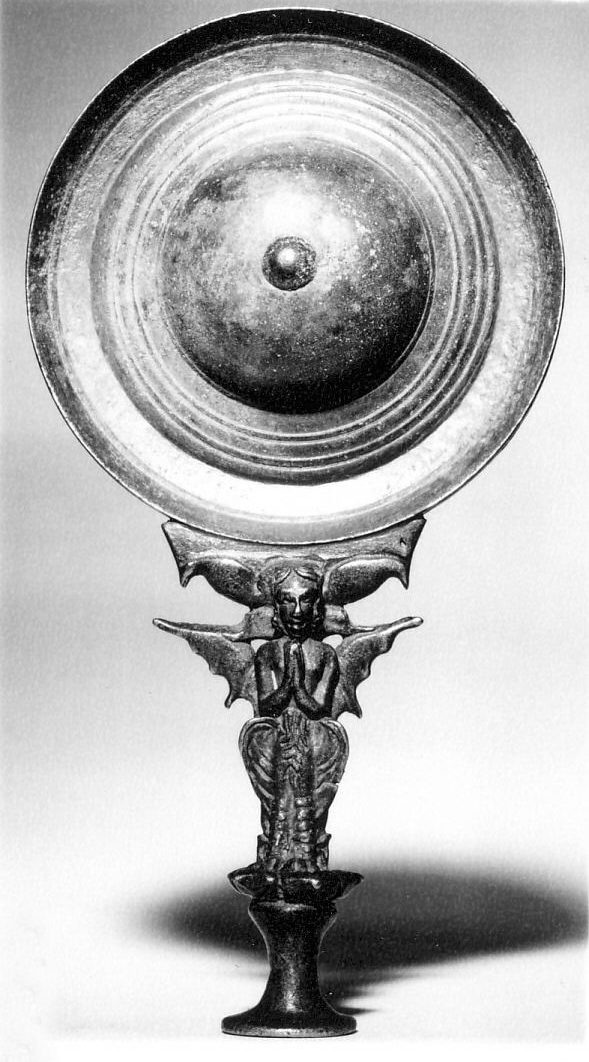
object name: mirror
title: Mirror and Handle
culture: indonesian, javanese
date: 901-1100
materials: bronze